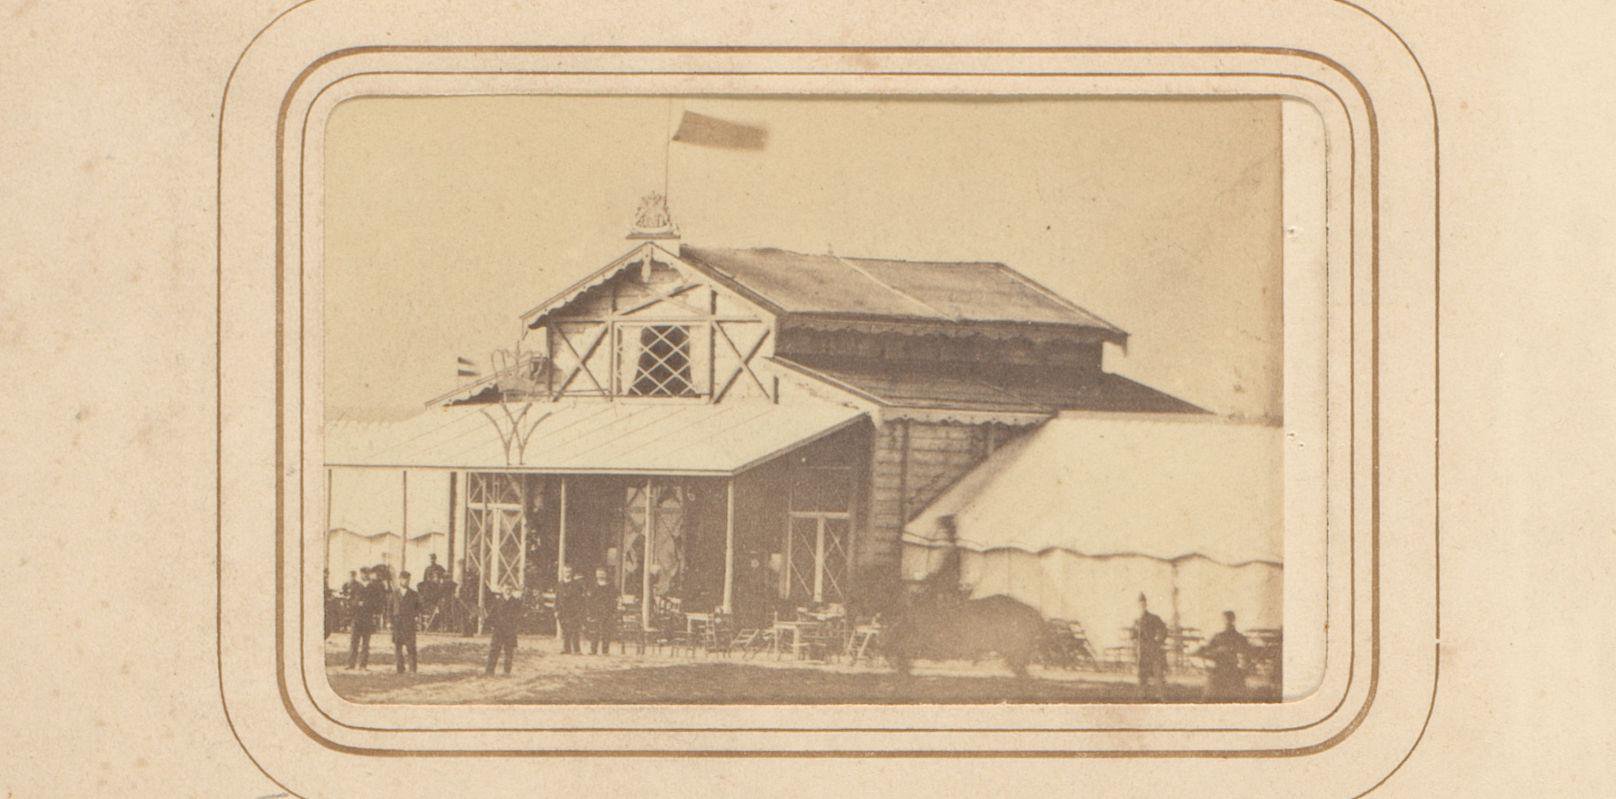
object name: carte de visite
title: Militairen voor een gebouw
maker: Anonymous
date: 1850-1869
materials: cardboard, photographic support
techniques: albumen print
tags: the soldier; the soldier's life, civic architecture; edifices; dwellings